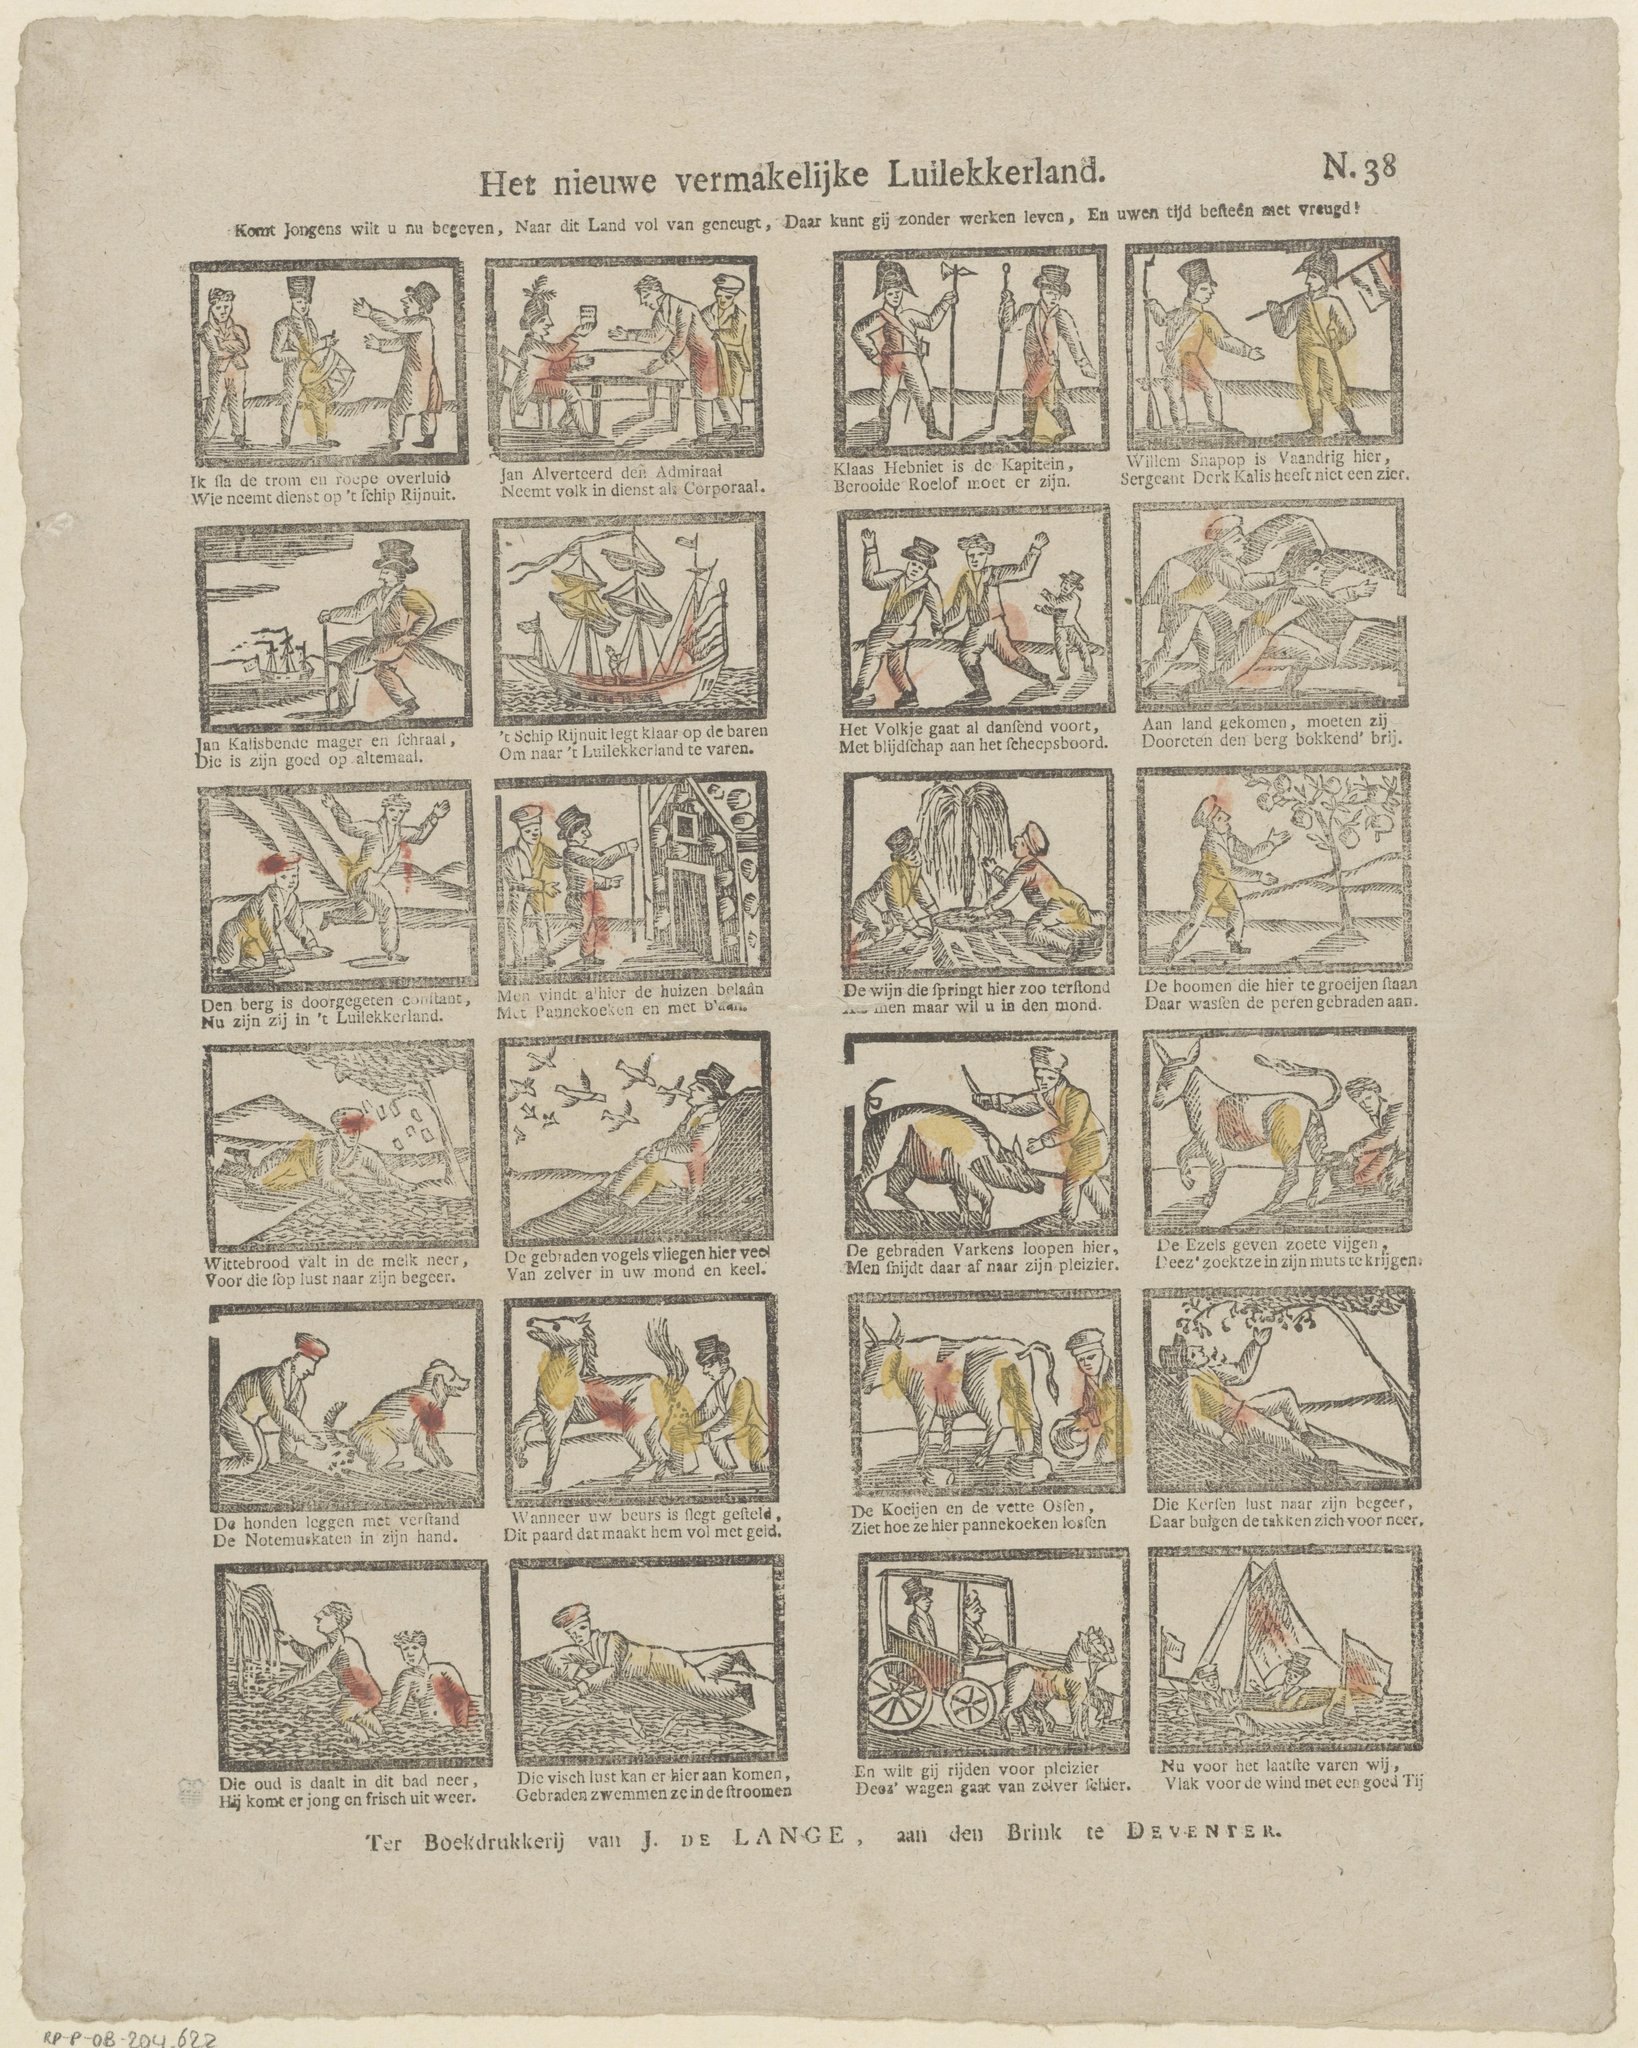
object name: popular print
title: Het nieuwe vermakelijke Luilekkerland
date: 1822-1849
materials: paper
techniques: colour, letterpress printing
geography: netherlands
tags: land of cockaigne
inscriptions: collector's mark: Lugt 2760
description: Blad met 24 voorstellingen van het Luilekkerland. Onder elke afbeelding een tweeregelig vers. Genummerd rechtsboven: N. 38.